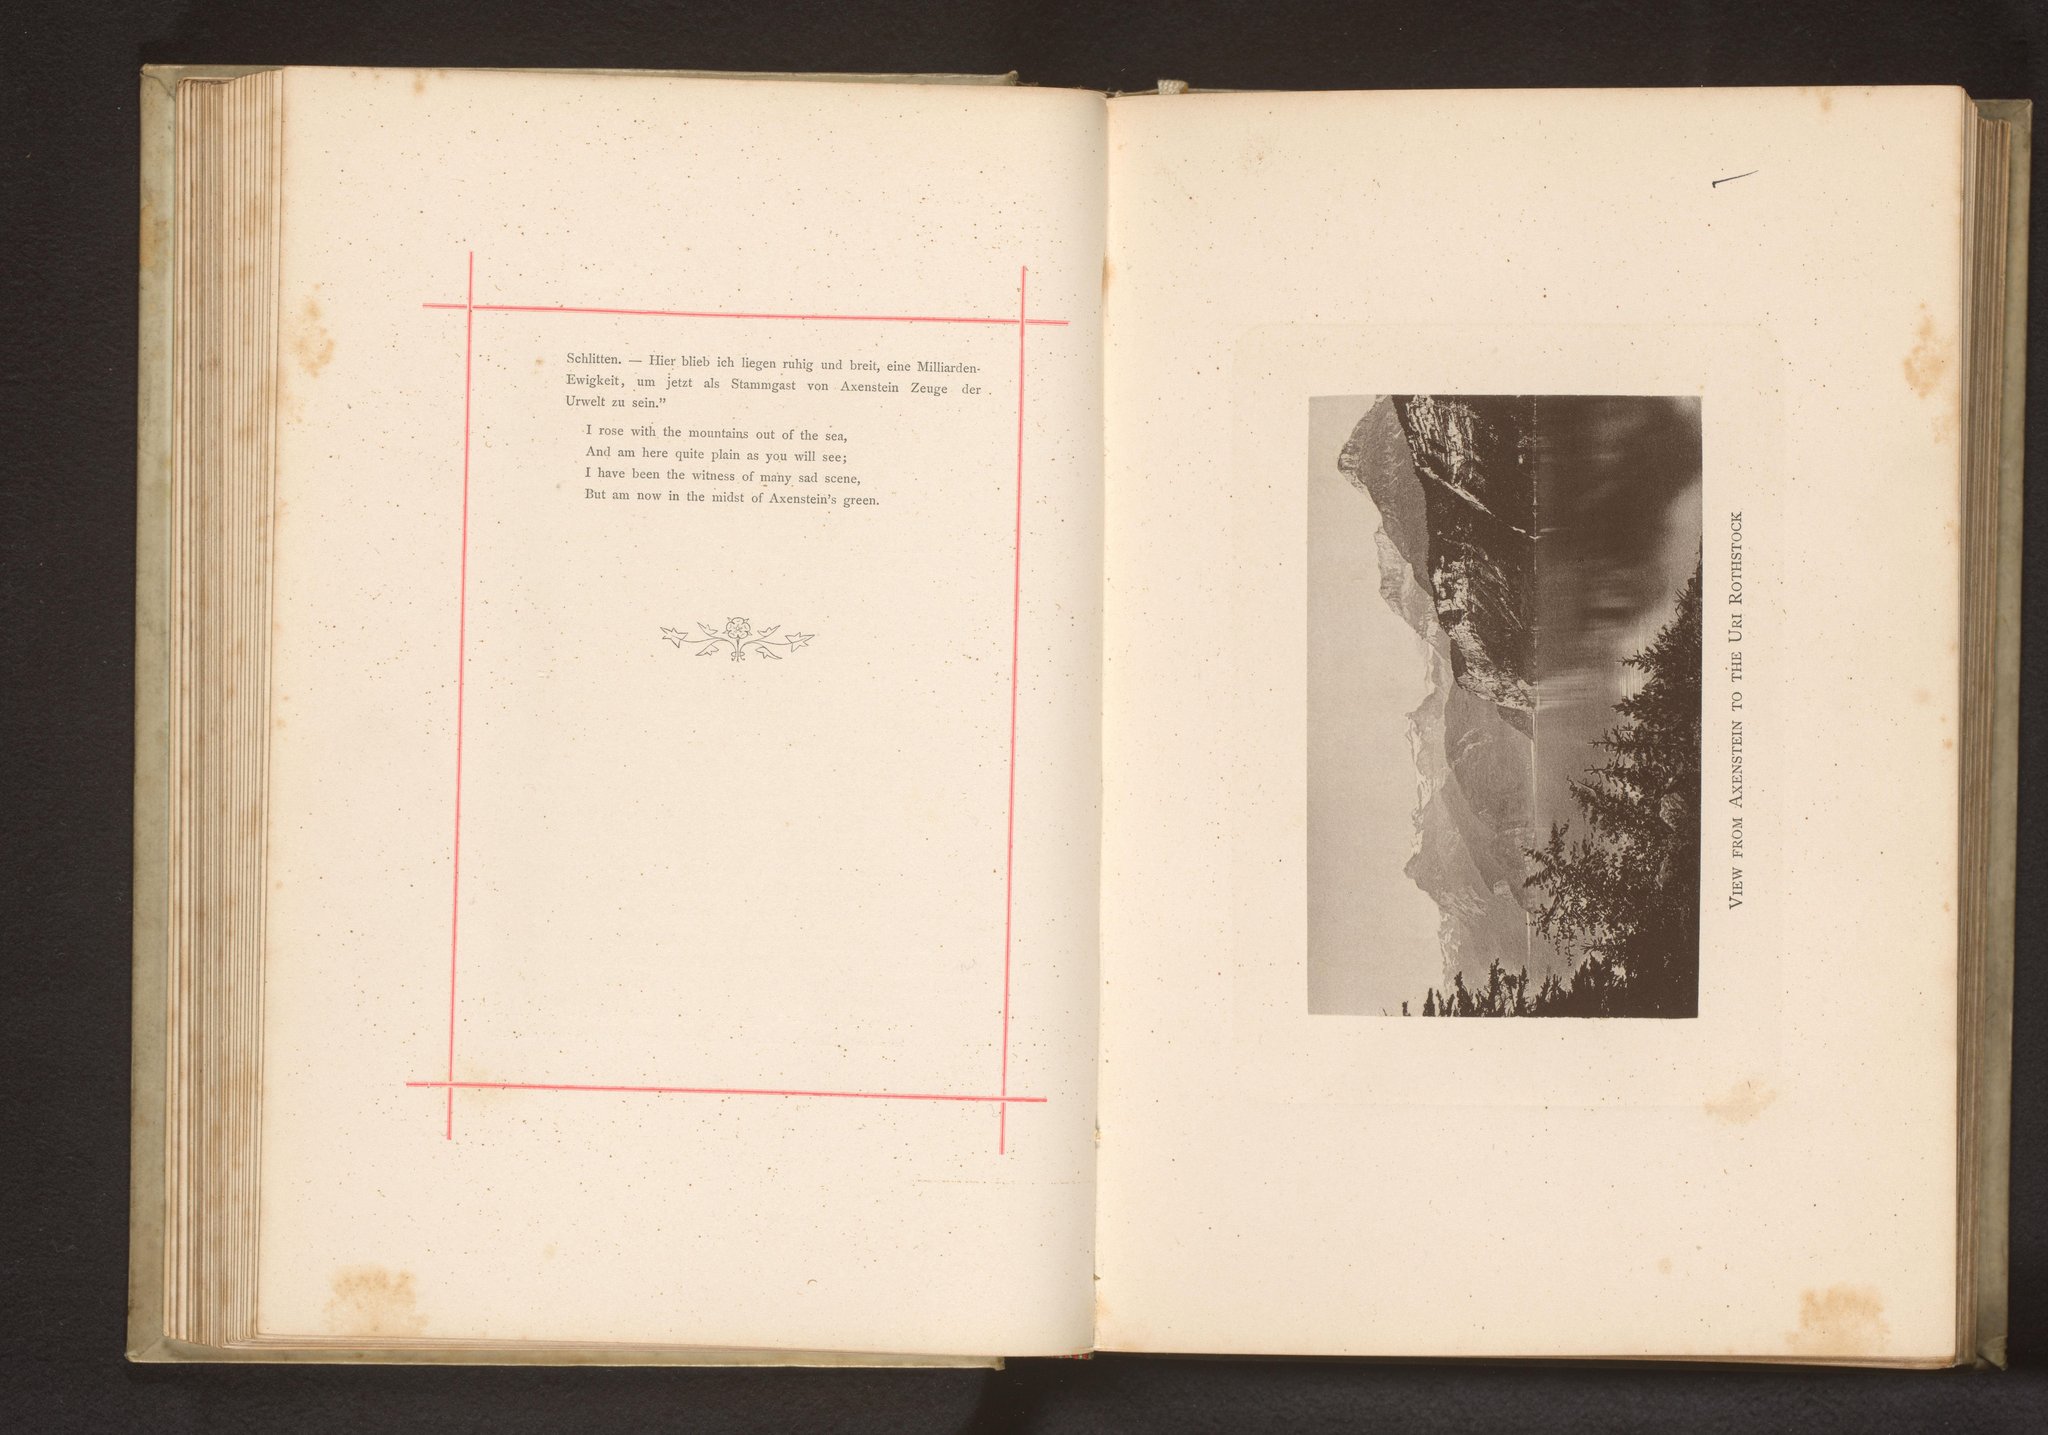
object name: page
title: Gezicht op de Urirotstock vanaf hotel Axenstein aan het Vierwoudstrekenmeer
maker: Anonymous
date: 1874-1884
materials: paper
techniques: photograph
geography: switzerland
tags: mountain-range, snow peaks